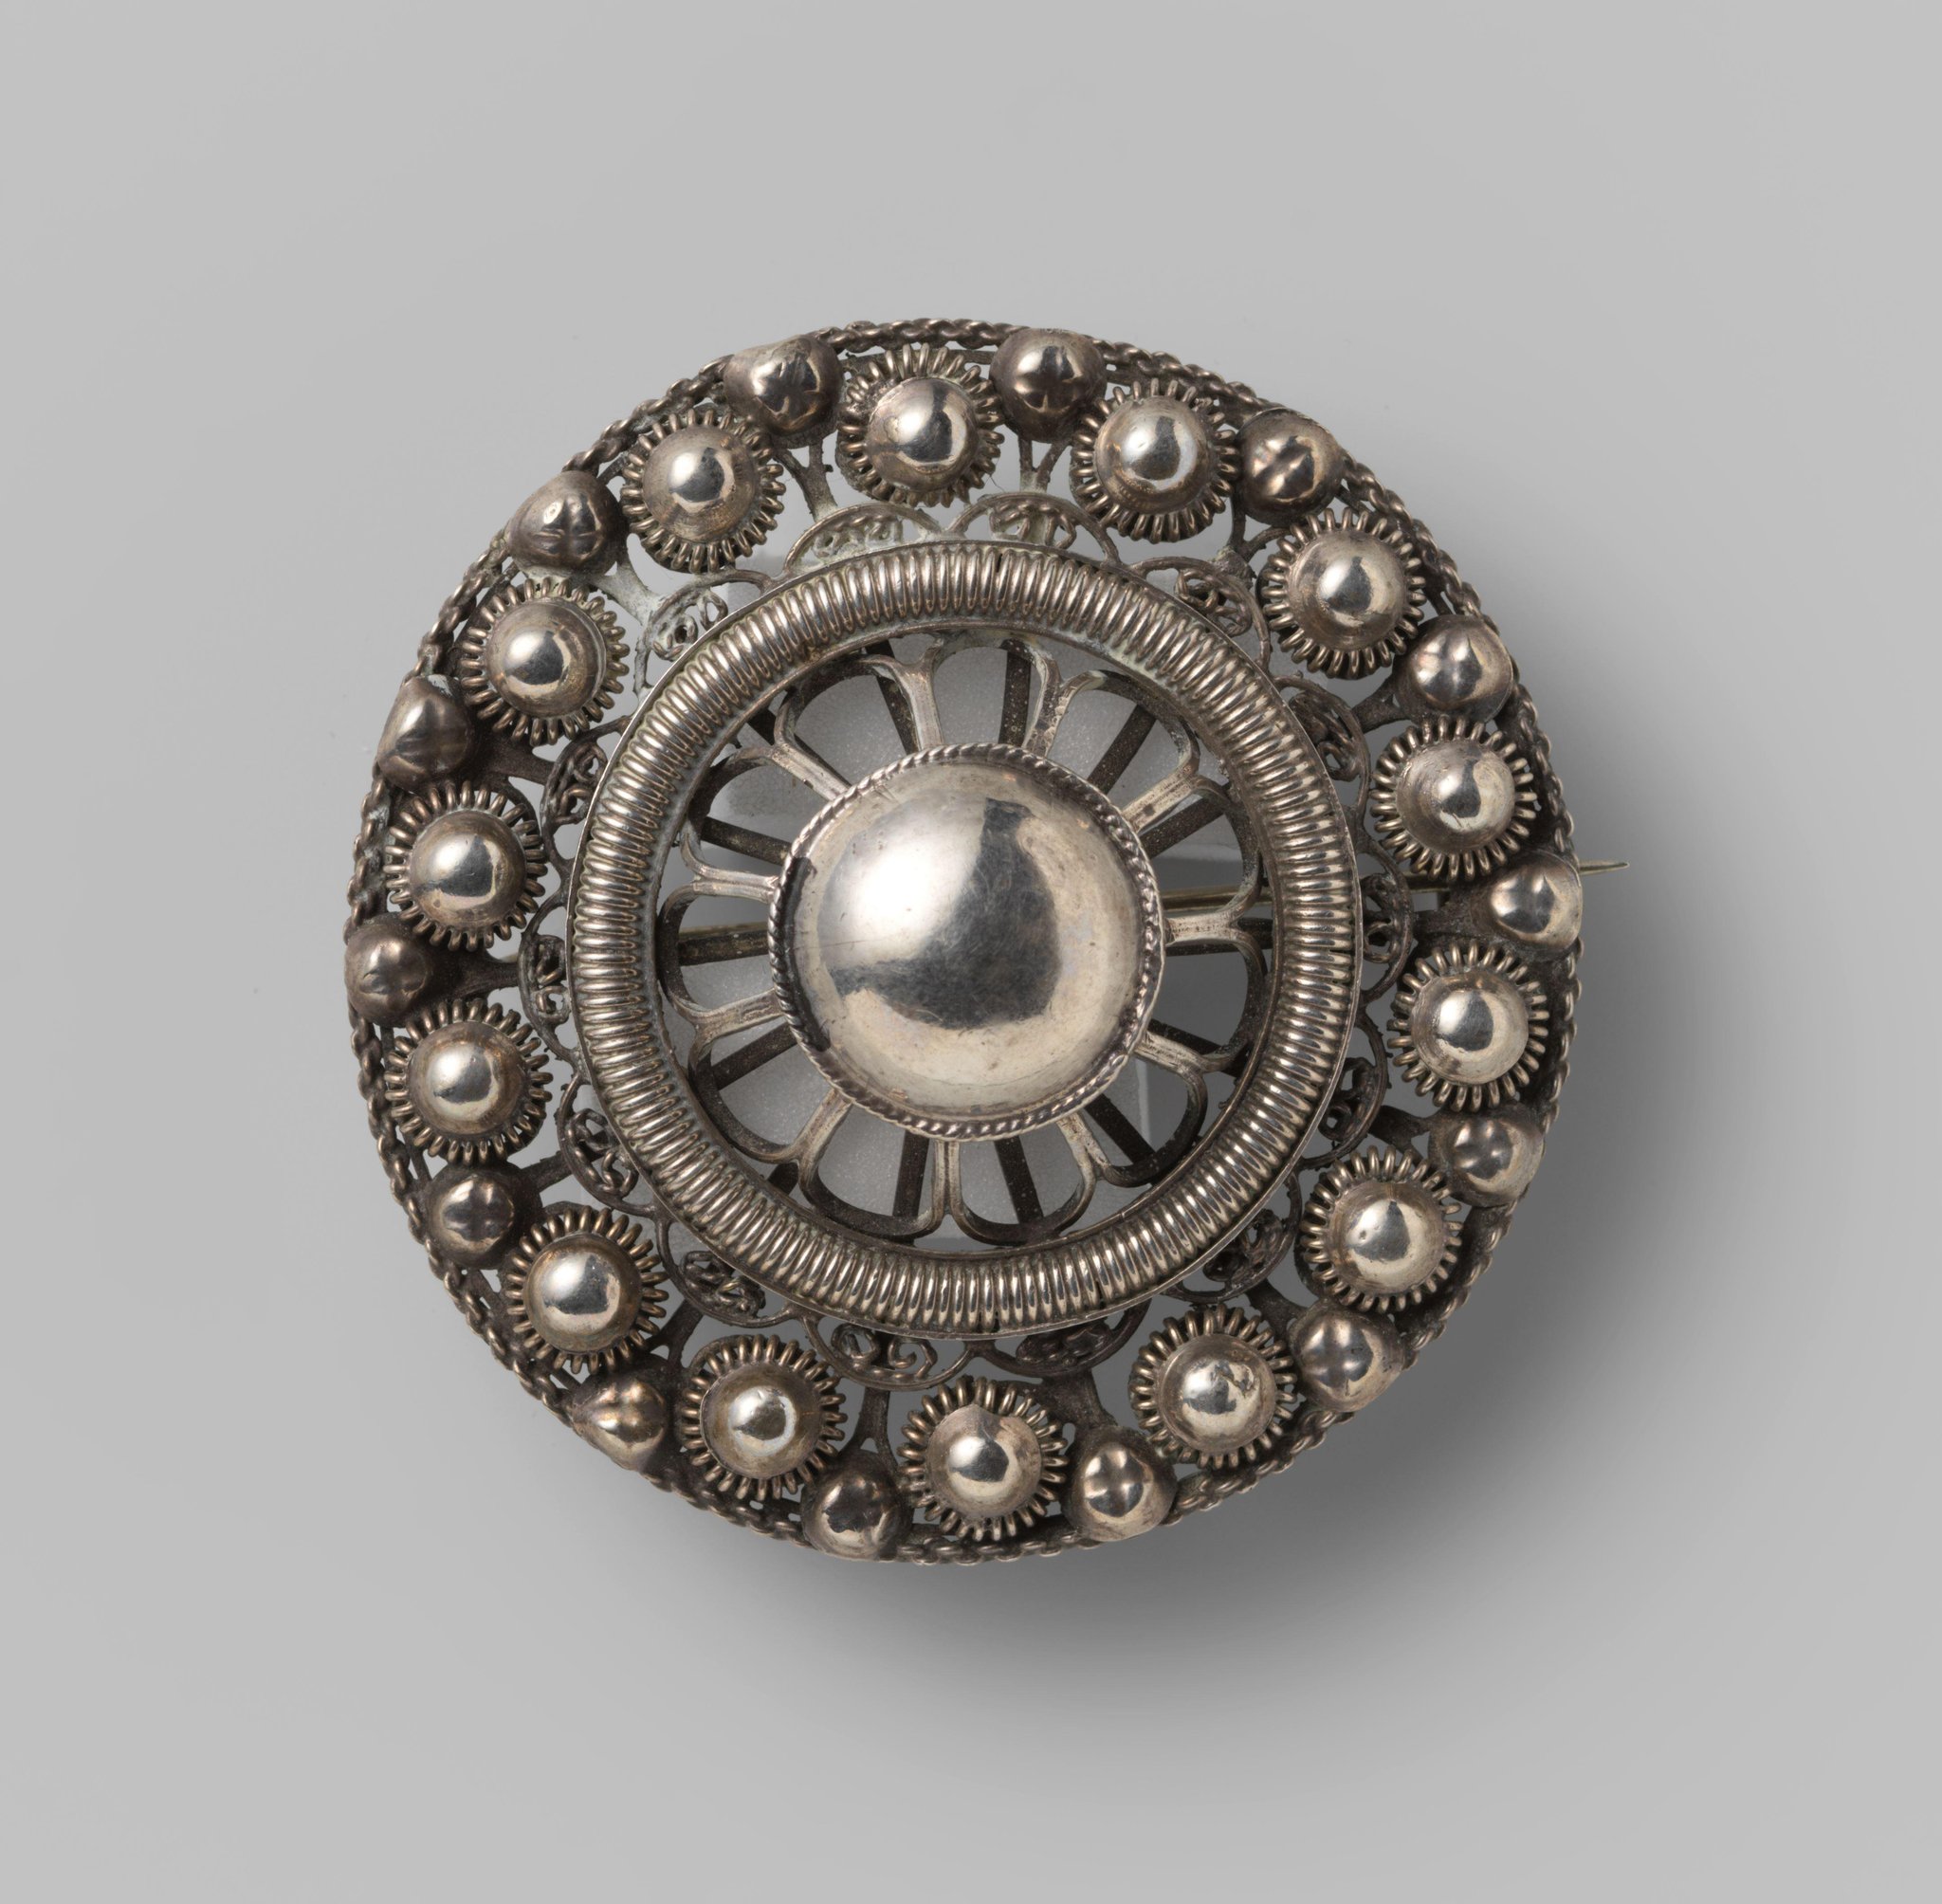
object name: sierspeld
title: Goese knop van zilver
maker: Anonymous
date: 1900-1940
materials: silver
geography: netherlands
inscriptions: : ‘ZII’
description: Goese knop van zilver voorzien van een haaksluiting met onedele brochering. De ring is gedragen door de moeder van Marjan Unger.